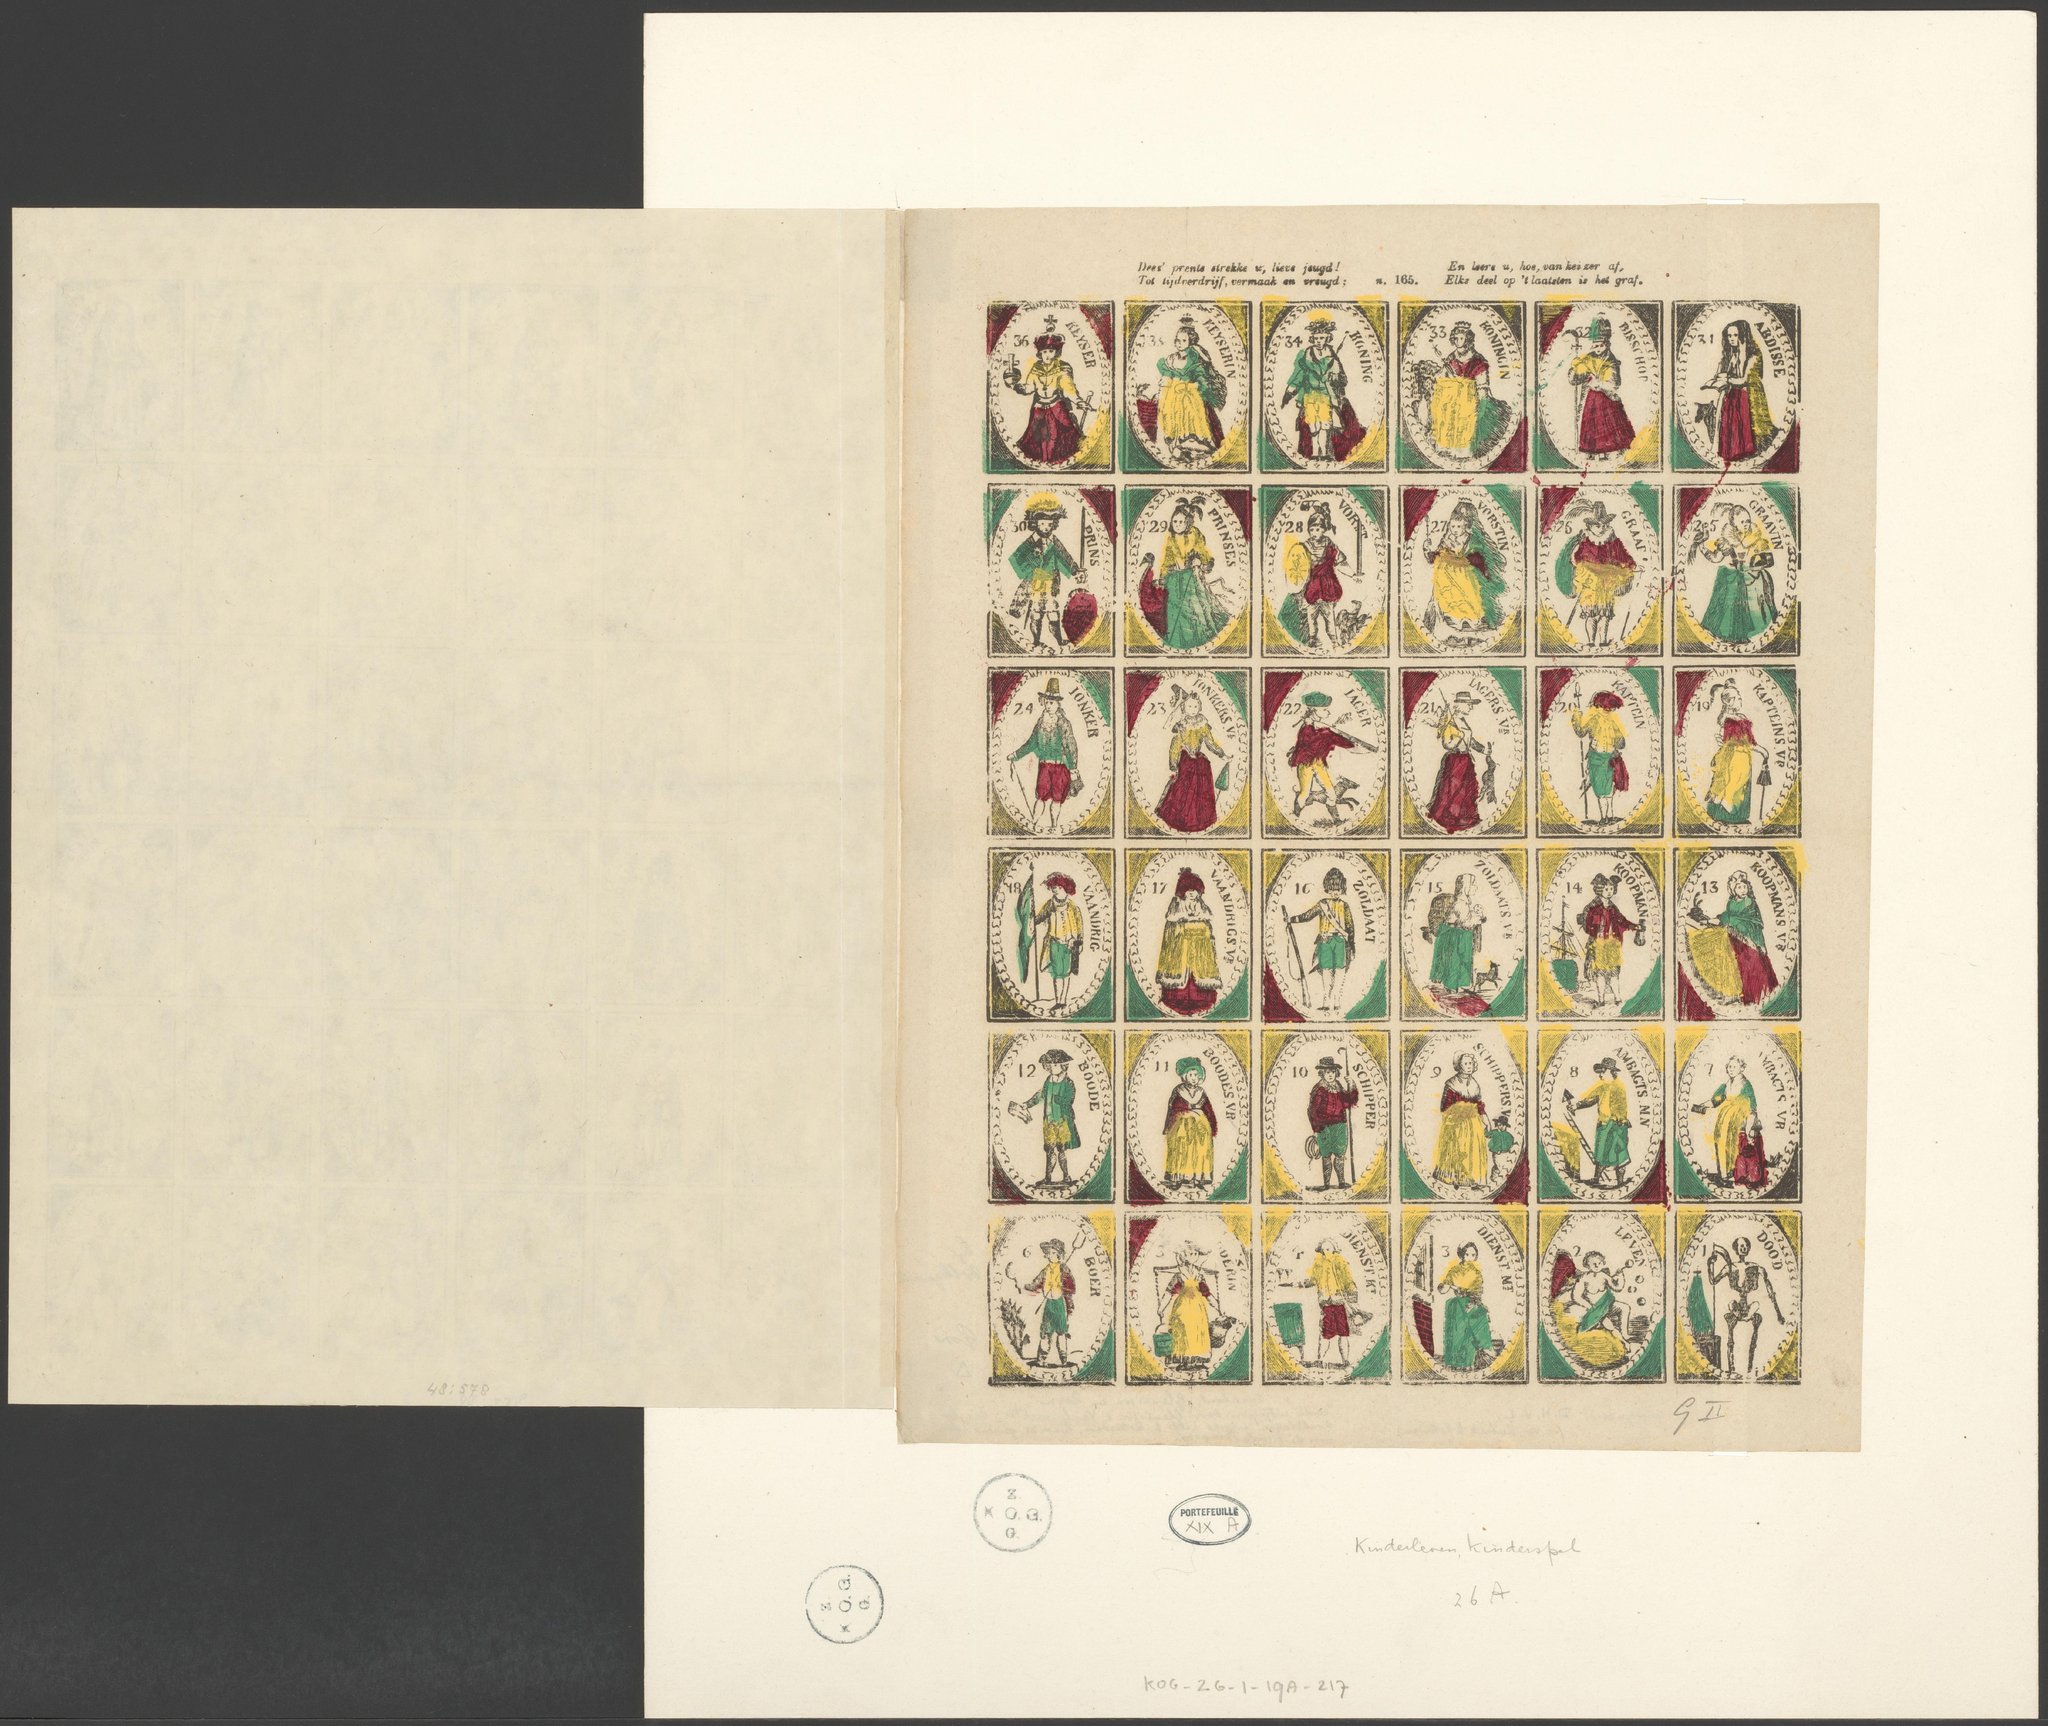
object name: print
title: Floskaartjes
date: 1833-1900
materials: paper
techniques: hand coloring, letterpress printing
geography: turnhout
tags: playing-cards, nobility and patriciate; chivalry, knighthood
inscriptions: collector's mark: Lugt 1641, stamp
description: Blad met 36 speelkaarten (floskaartjes) met voorstellingen van verschillende figuren. De afbeeldingen vormen achttien paren, aflopend genummerd van bovenaan links nummer 36 tot onderaan rechts nummer 1. Op de twee laagste nummers na tonen ze zeventien koppels, man en vrouw, met de man net één nummer hoger dan de vrouw, waarbij elk paar een beroep of een maatschappelijke positie voorstelt. Genummerd midden boven: n. 165. Onderwerpsrubrieken binnen de Atlas Zeden en Gewoonten: Zeden en Gewoonten in Engeren Zin, Des menschen beging, midden en einde, Kinderleven – Kinderspel en Kinderprenten.